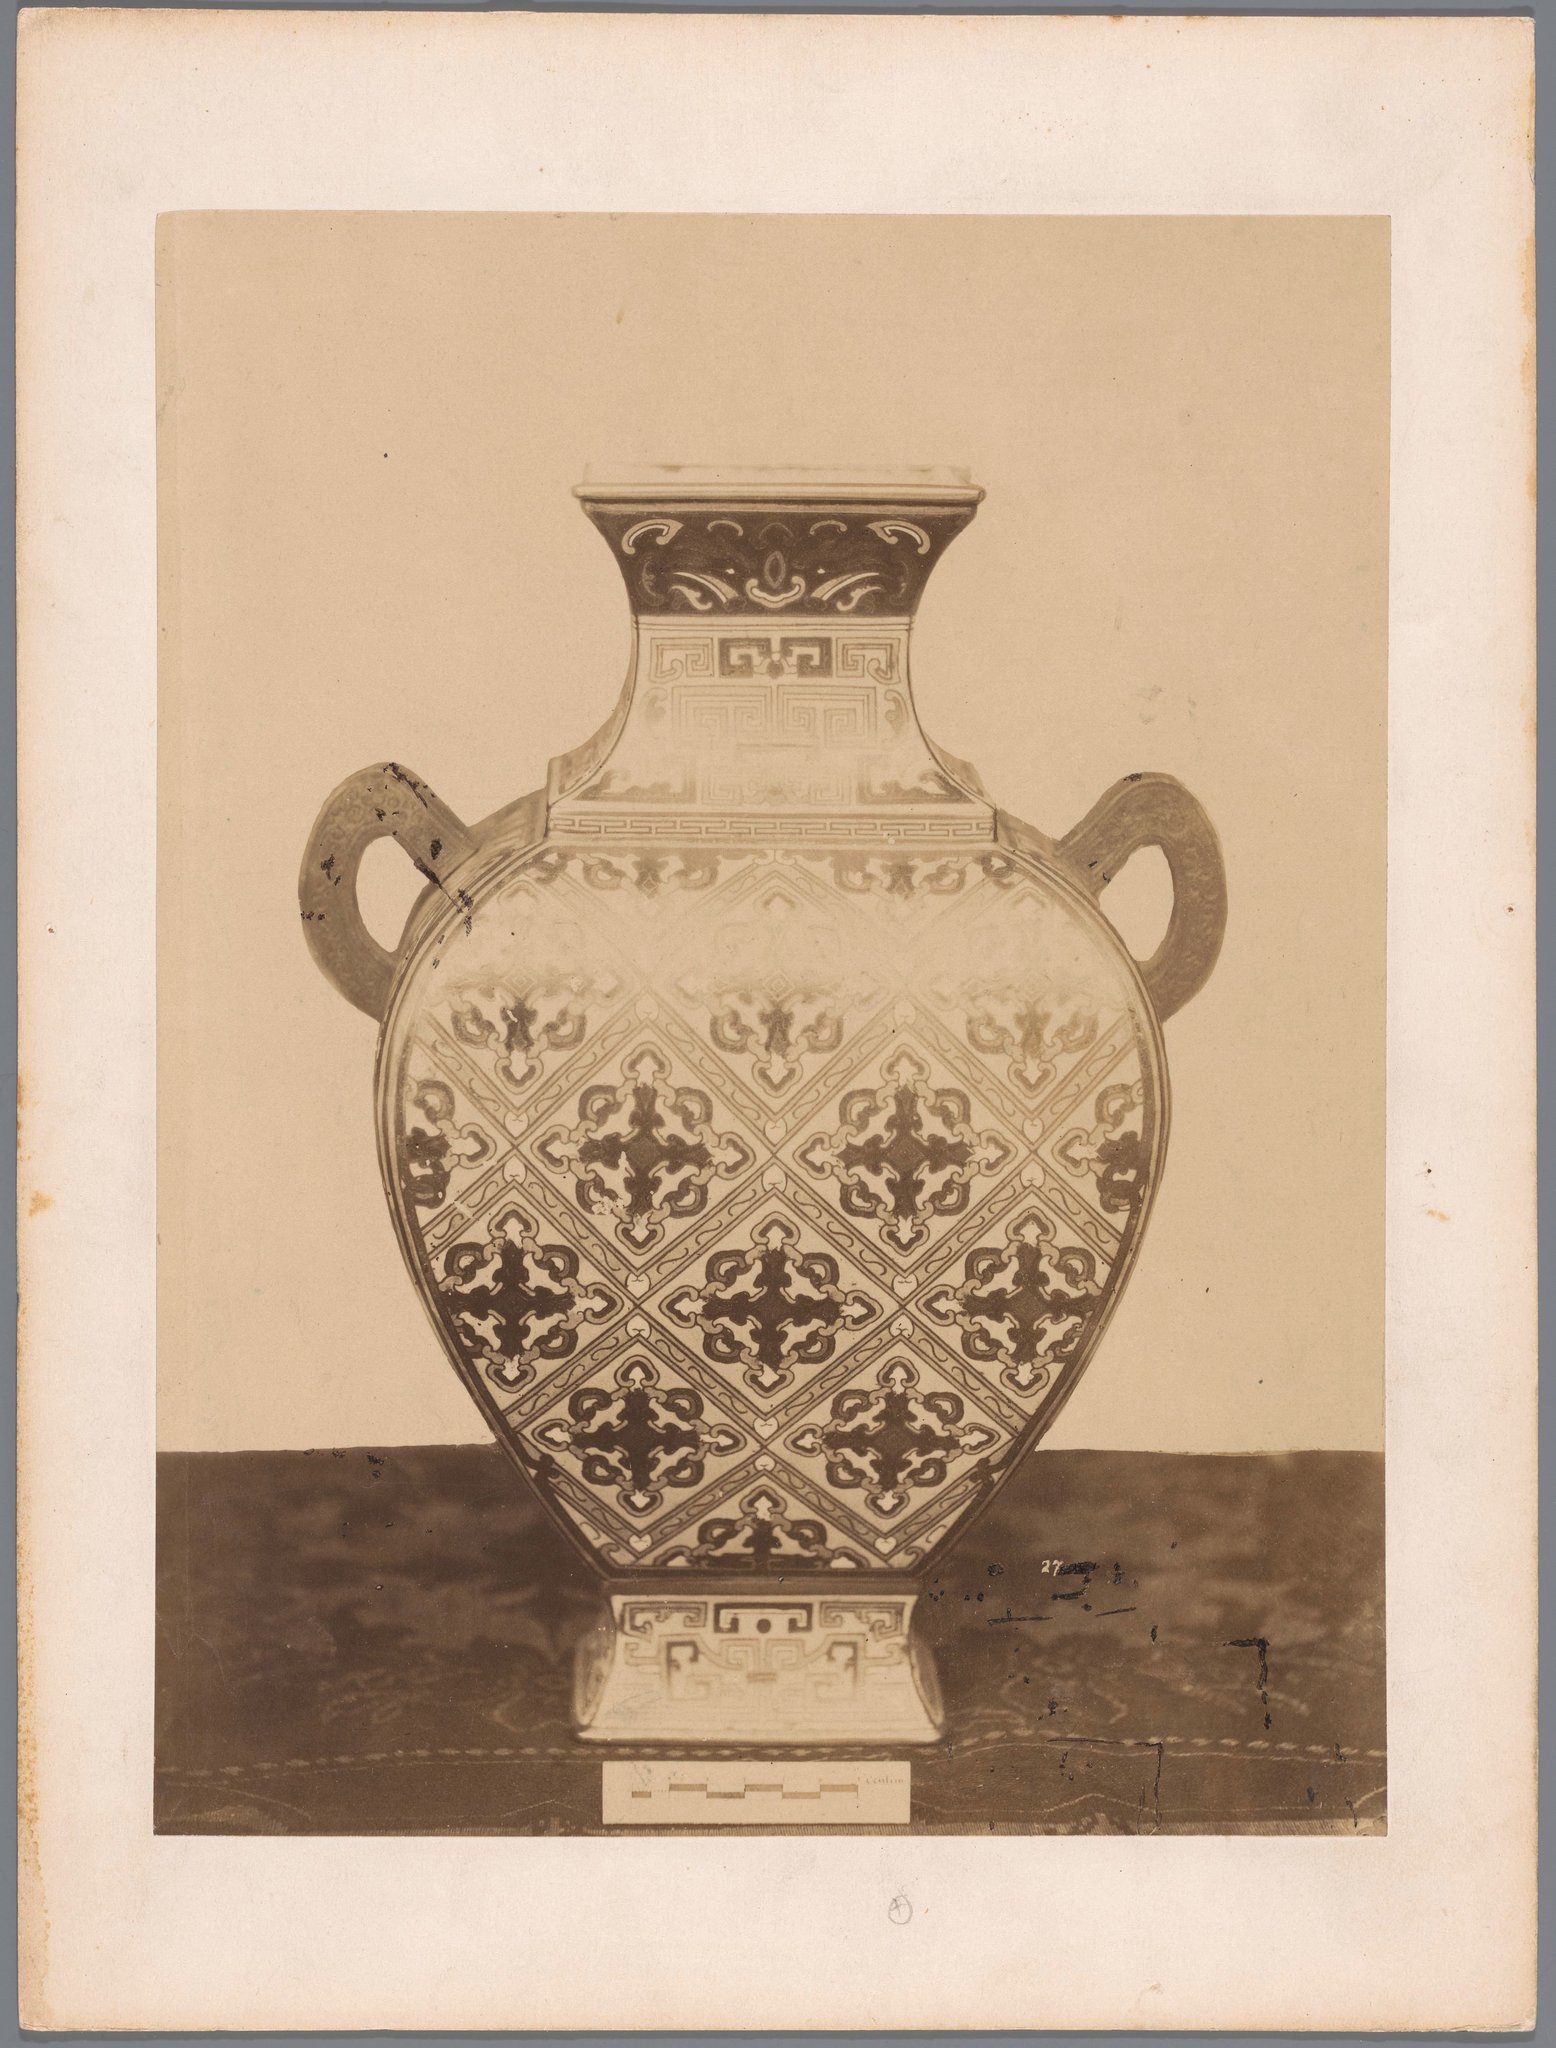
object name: photograph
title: Vaas met twee oren gedecoreerd met een geometrisch motief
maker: Anonymous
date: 1875-1900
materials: cardboard, photographic support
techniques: albumen print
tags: applied arts, arts and crafts; industrial design, ornament ~ geometric motifs, container of ceramics: jar, jug, pot, vase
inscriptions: collector's mark: Lugt 3937, number: ‘27’